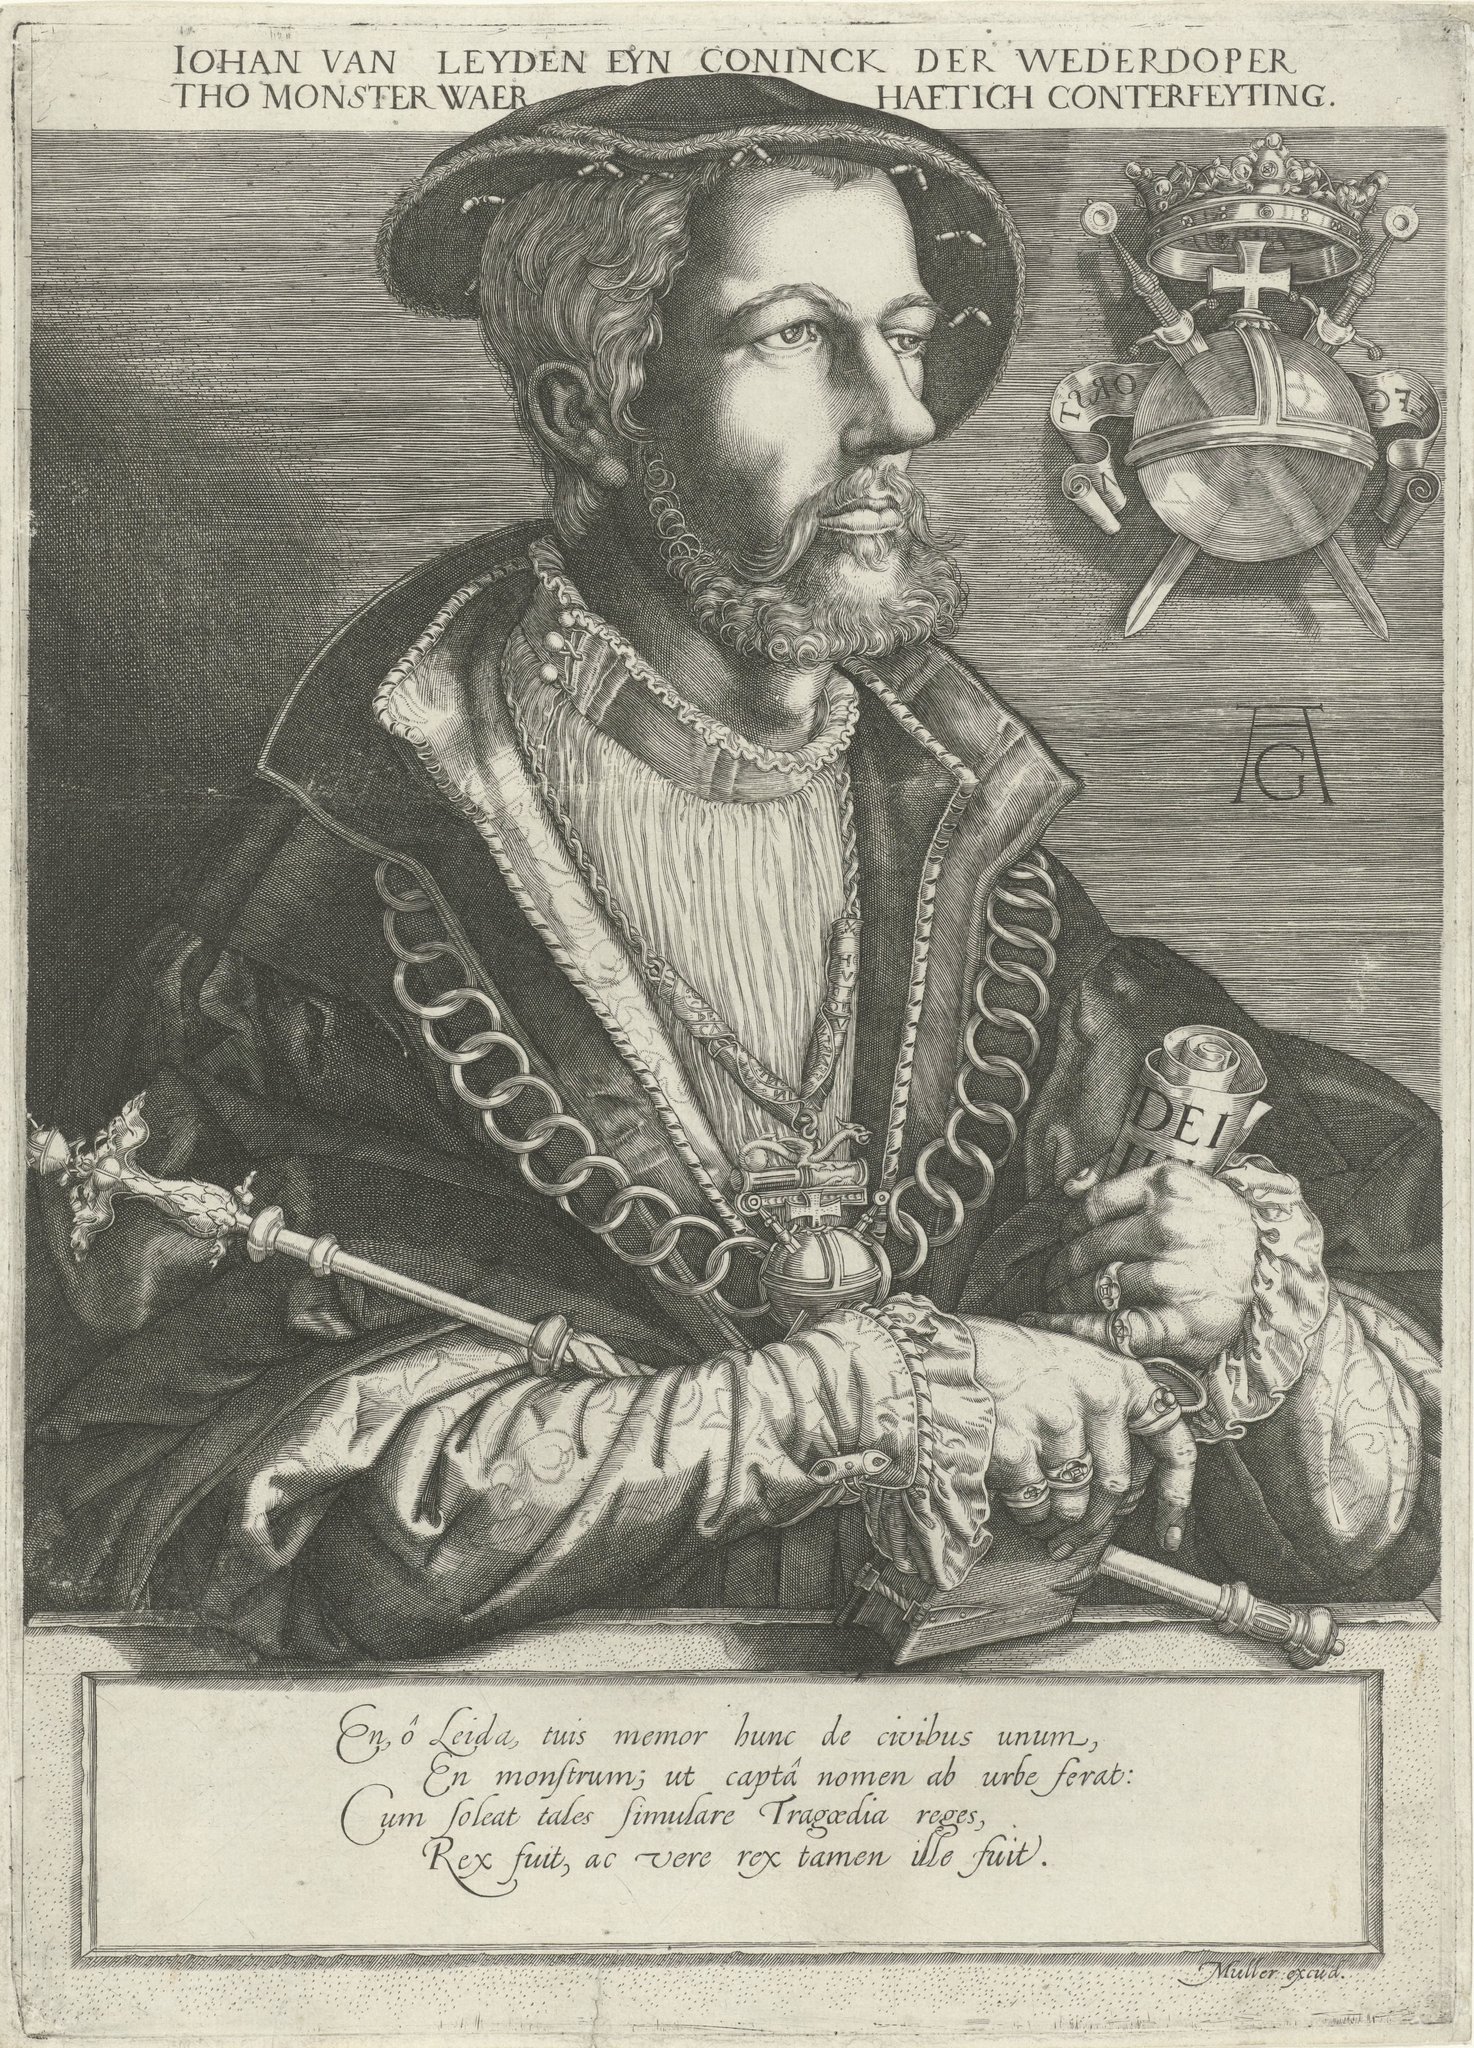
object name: print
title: Portret van Jan Beukelszoon van Leiden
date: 1613-1617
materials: paper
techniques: engraving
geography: amsterdam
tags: orb (symbol of sovereignty; sphere with cross on top), sceptre, staff (symbol of sovereignty)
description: Portret van Jan Beukelszoon van Leiden, leider en zelfuitgeroepen koning van de wederdopers in Münster. Om zijn hals een ketting, onder de arm een scepter en in zijn handen een Bijbel en een pamflet. Rechtsboven een gekroonde rijksappel, doorboord met twee zwaarden. Onderaan een vierregelig vers in het Latijn.